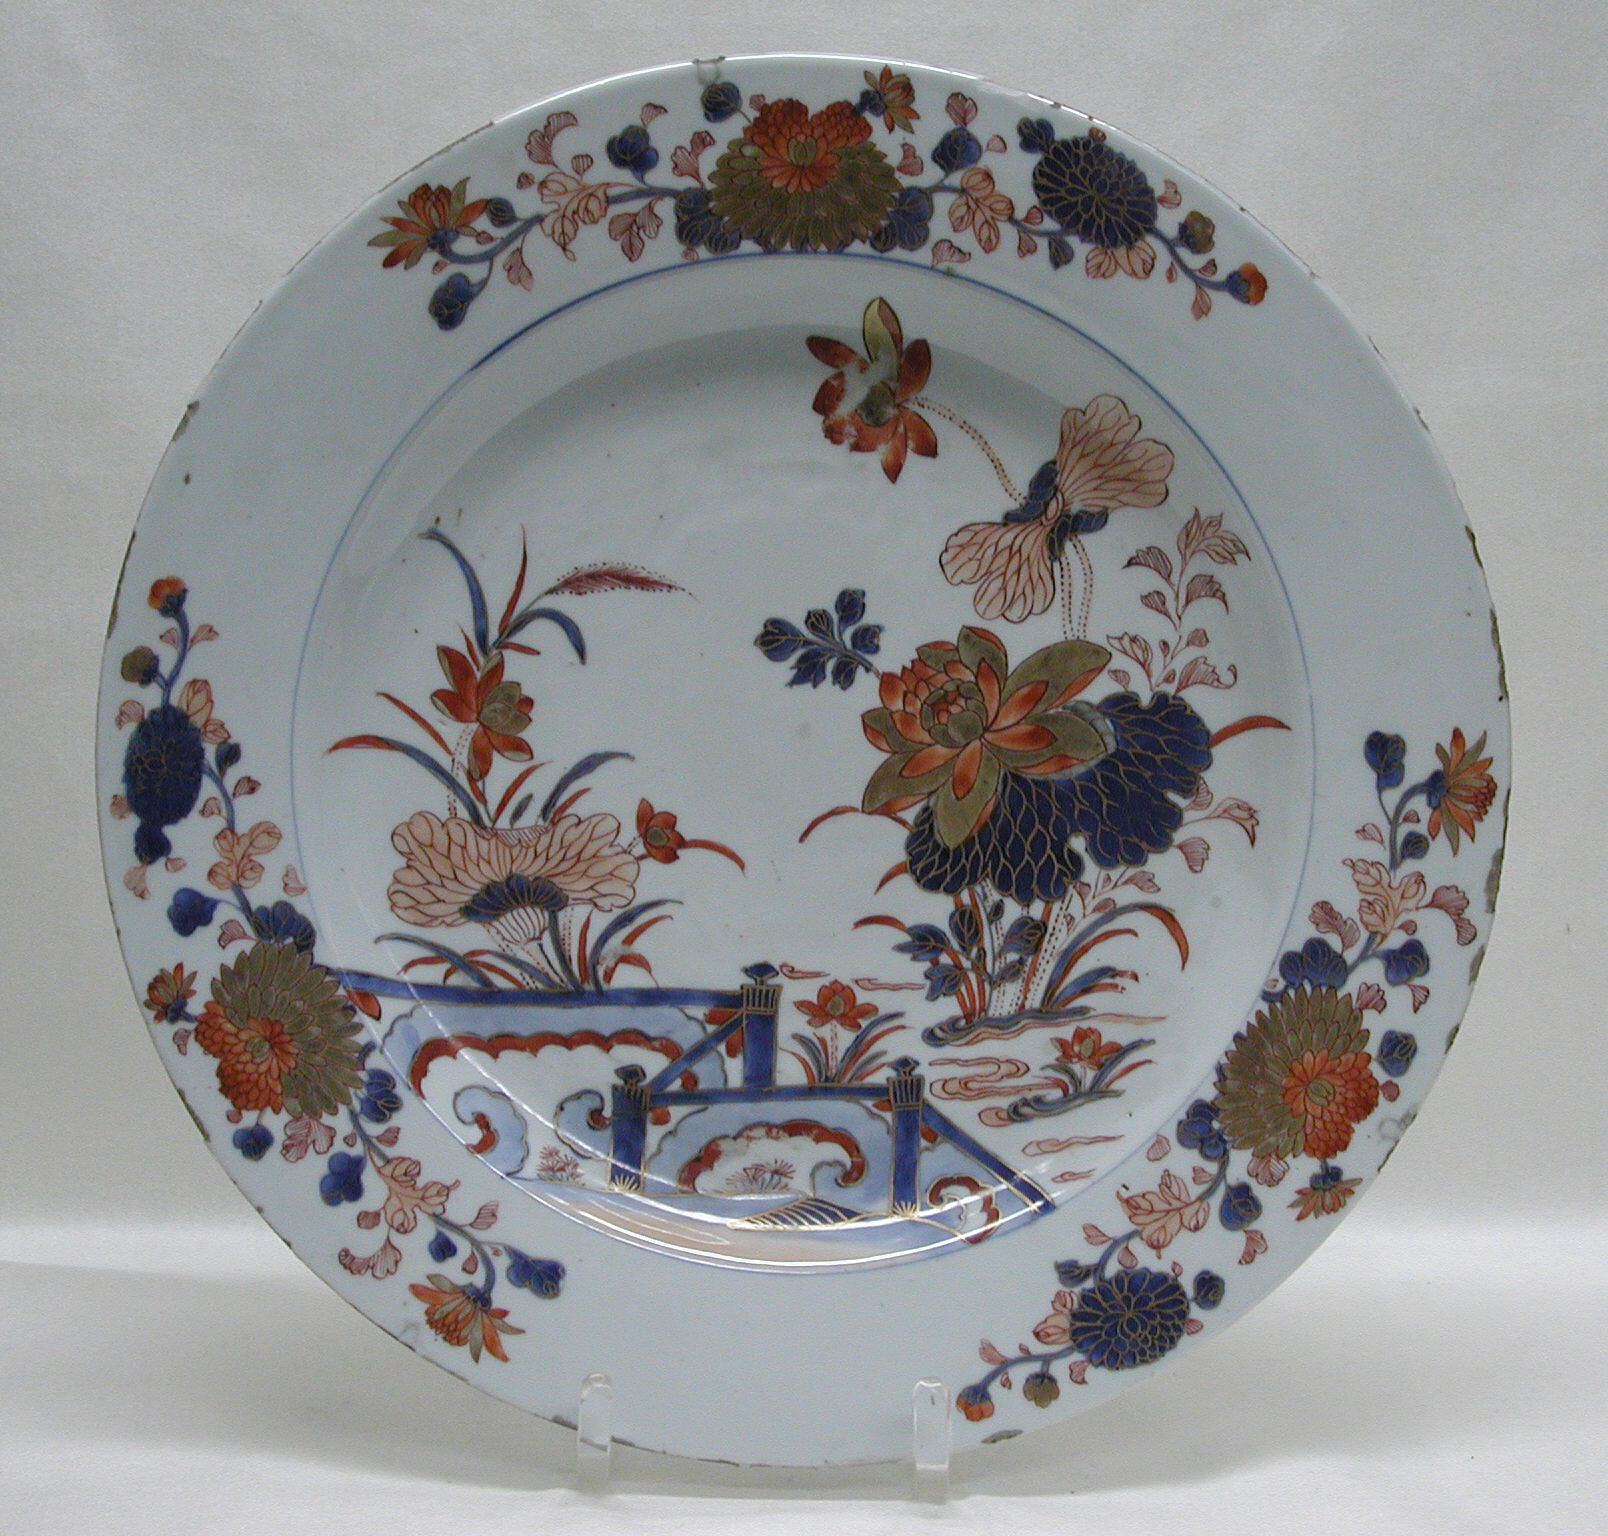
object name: dish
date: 1725-1750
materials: hard paste porcelain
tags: flowers